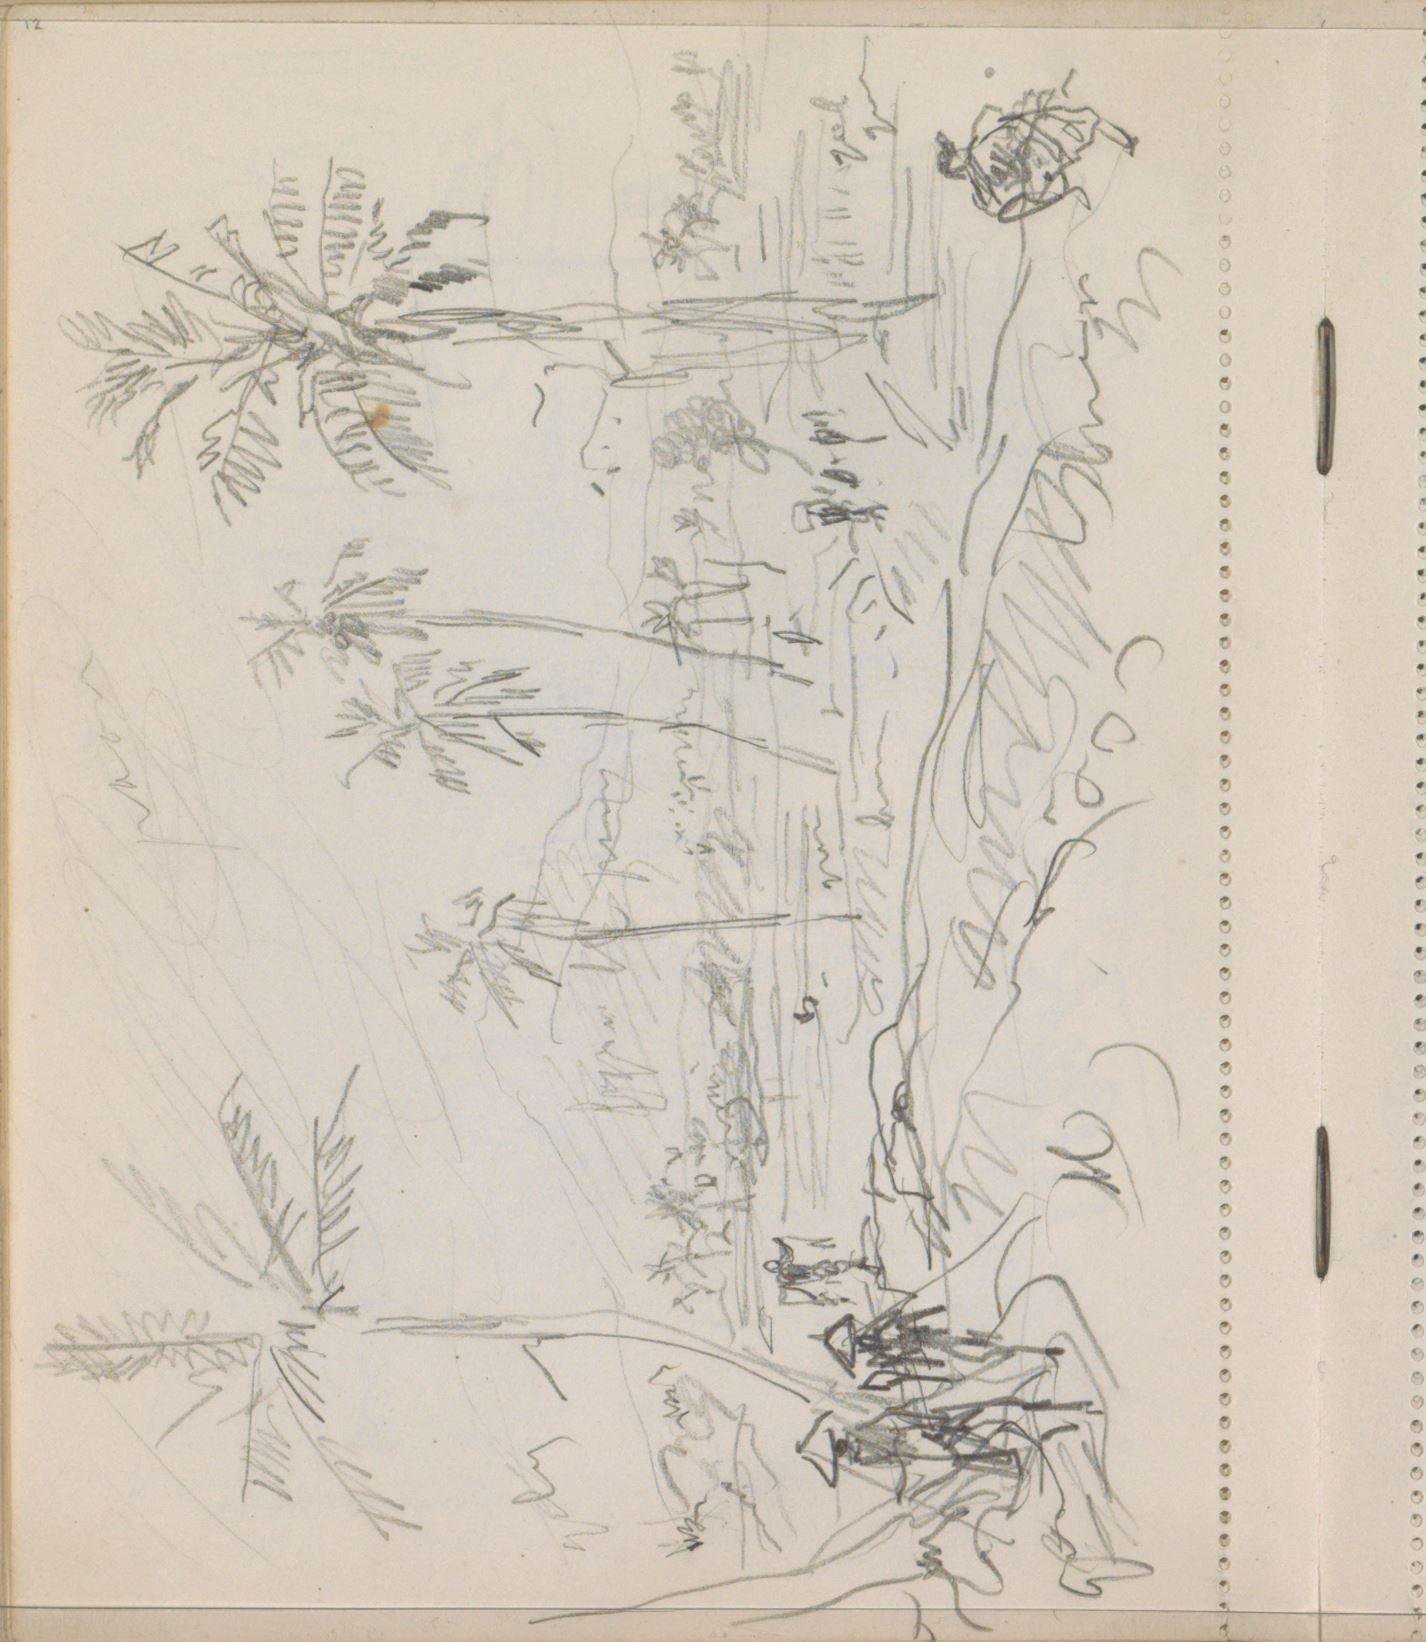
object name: sketchbook leaf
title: Sawa's met palmbomen en figuren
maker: marius bauer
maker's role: draughtsman, print maker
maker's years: 1867-1932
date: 1925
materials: paper, pencil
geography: java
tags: sawahs, rice paddies, trees: palm-tree, landscapes (+ landscape with figures, staffage)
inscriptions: kleurnotitie, handgeschreven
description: Pagina 12 uit een schetsboek met 67 bladen.